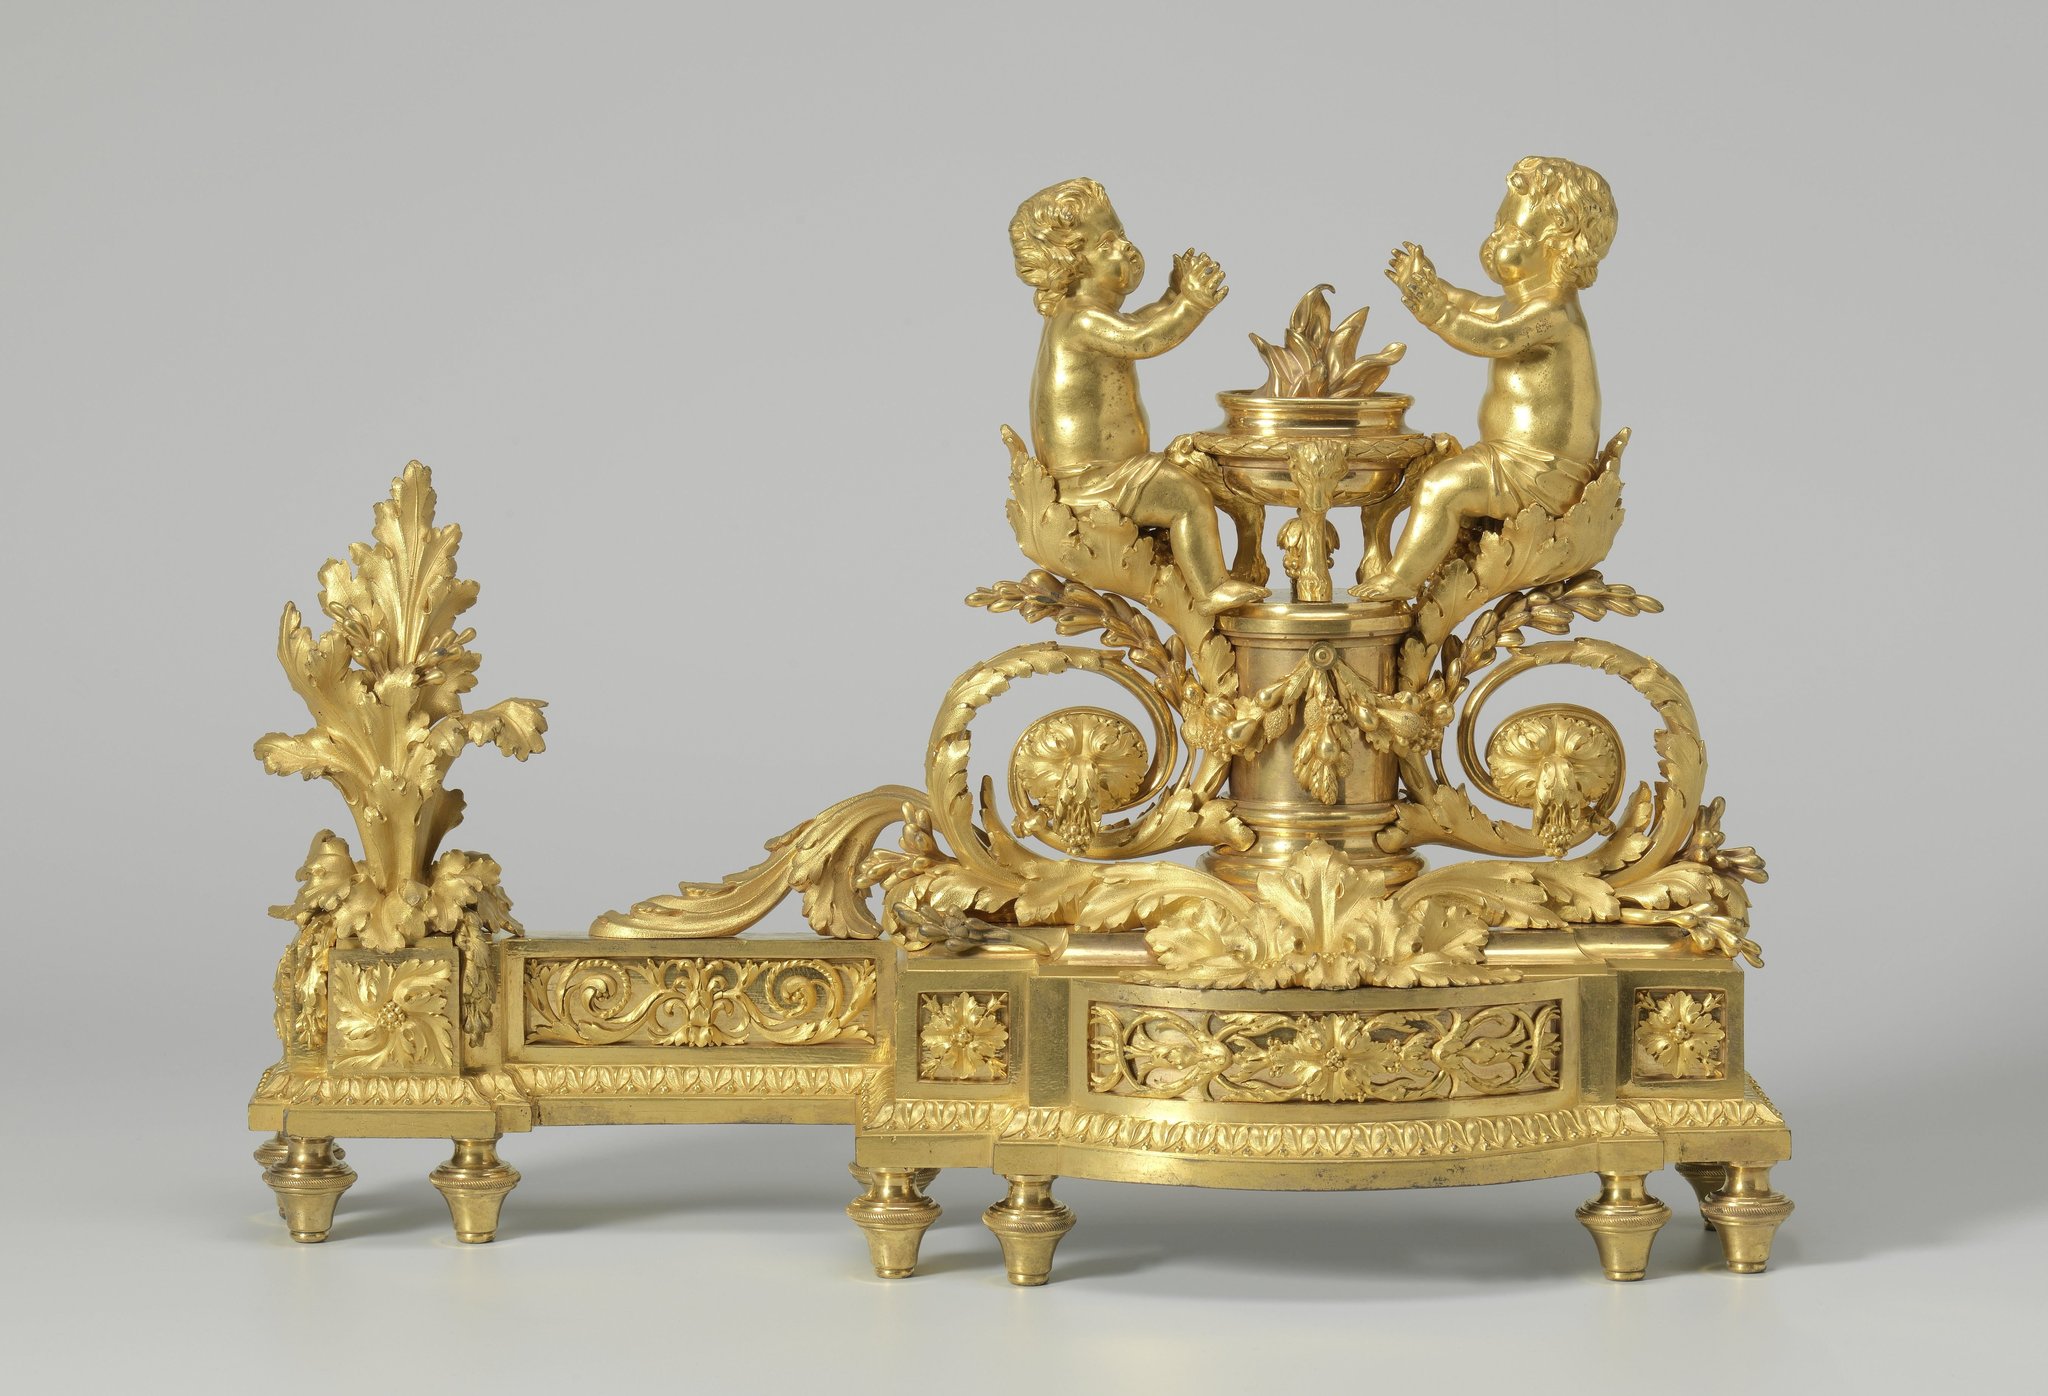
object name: heating system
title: Vuurbok van verguld brons met putti die zich aan een vlam warmen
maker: Anonymous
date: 1780-1790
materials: bronze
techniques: gilding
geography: paris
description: Verguld bronzen vuurbok. Het uitgeschulpte deel van het basement draagt een cylindervormig voetstuk waarop een olielamp met vlam. Aan het voetstuk ontspringen onderaan twee bladvoluten en boveaan twee acanthusbladeren, als zetel voor putti die zich aan de vlam warmen. Een recht stuk met opengewerkte blad- en bloemmotieven leidt naar een klein vierkant deel, versierd met bladrozetten- en ranken, die omhoogstekende acanthusbladeren draagt. Afwerking met rozetten, eierlijst en bladmotieven.